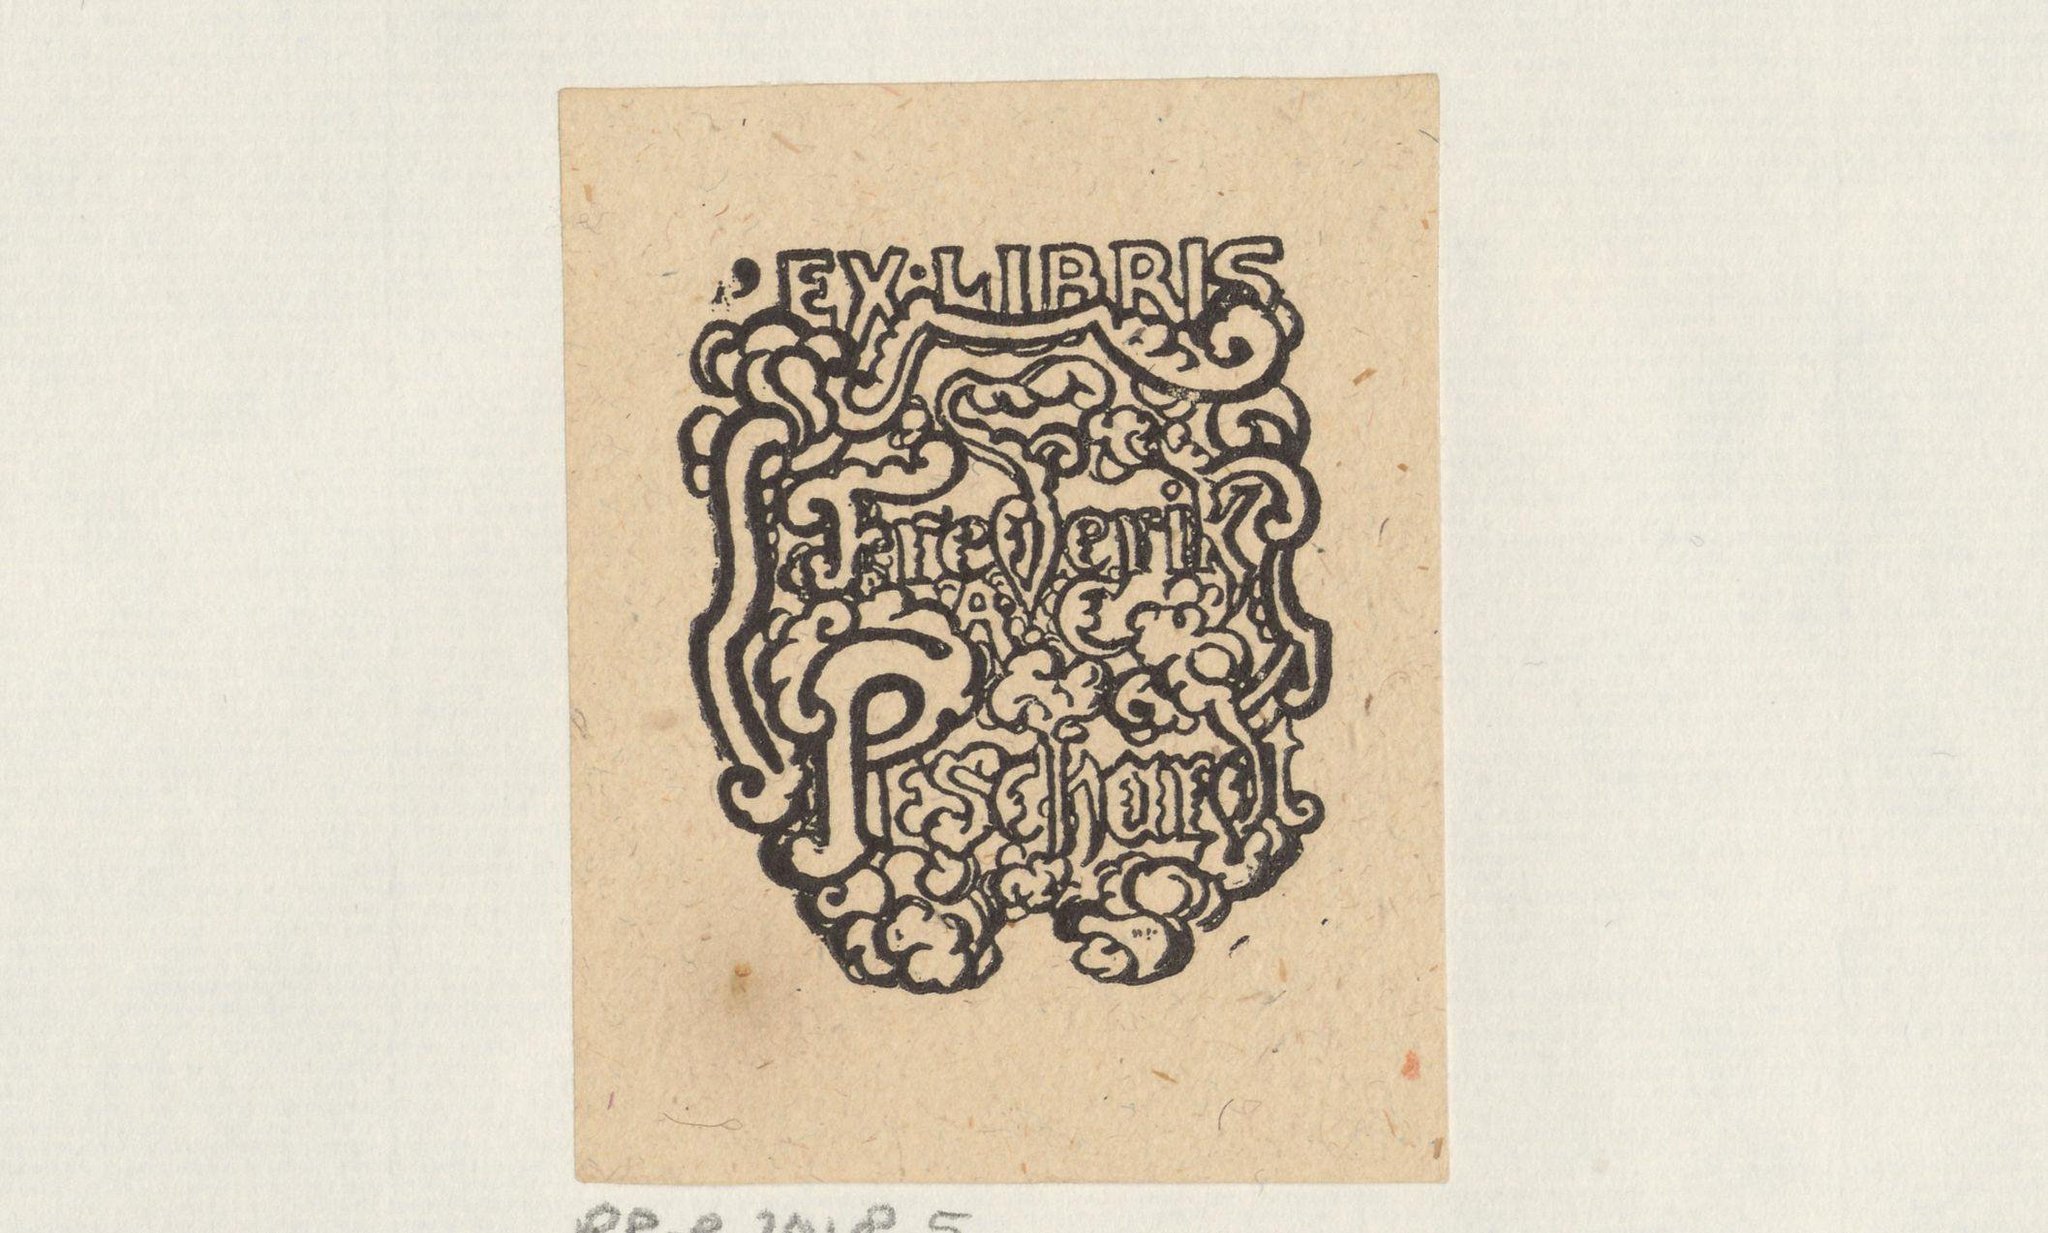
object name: bookplate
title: Ex libris van Frederik Peschardt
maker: Anonymous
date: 1899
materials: paper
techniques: printing block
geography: denmark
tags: clouds